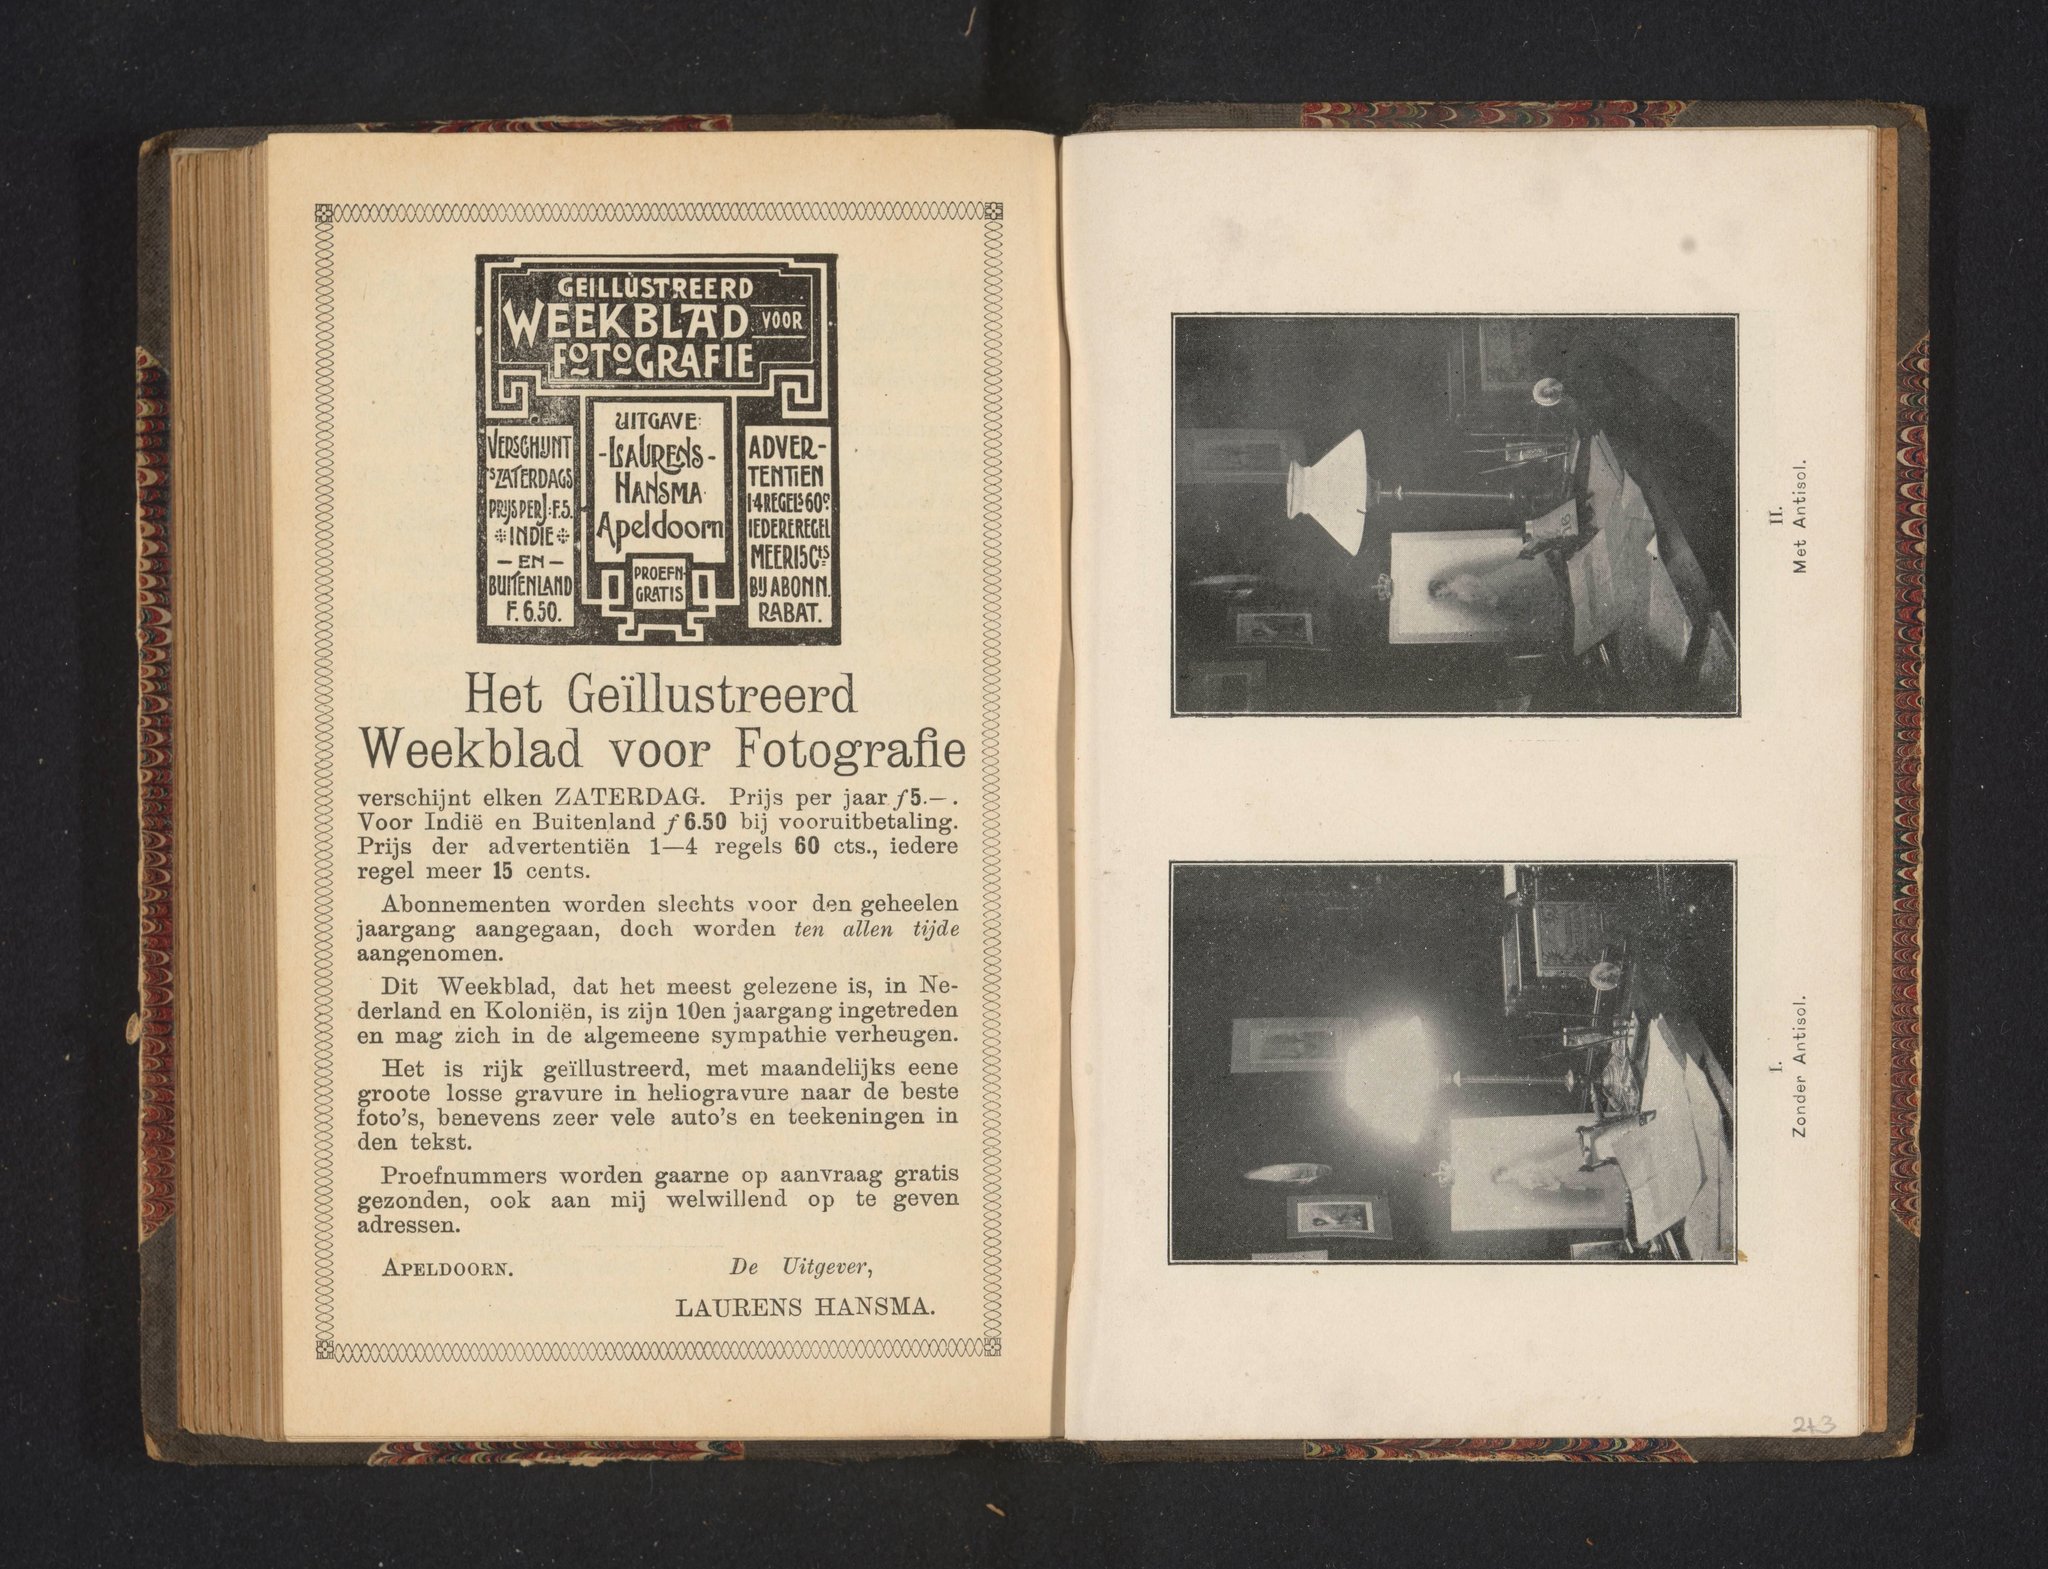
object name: page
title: Voorbeeldopname, met daarop een bureau met papieren, pennen en een lamp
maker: Anonymous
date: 1897-1902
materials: paper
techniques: autotype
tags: writing-table, writing-desk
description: Prent één van veertien prenten na pagina 241.